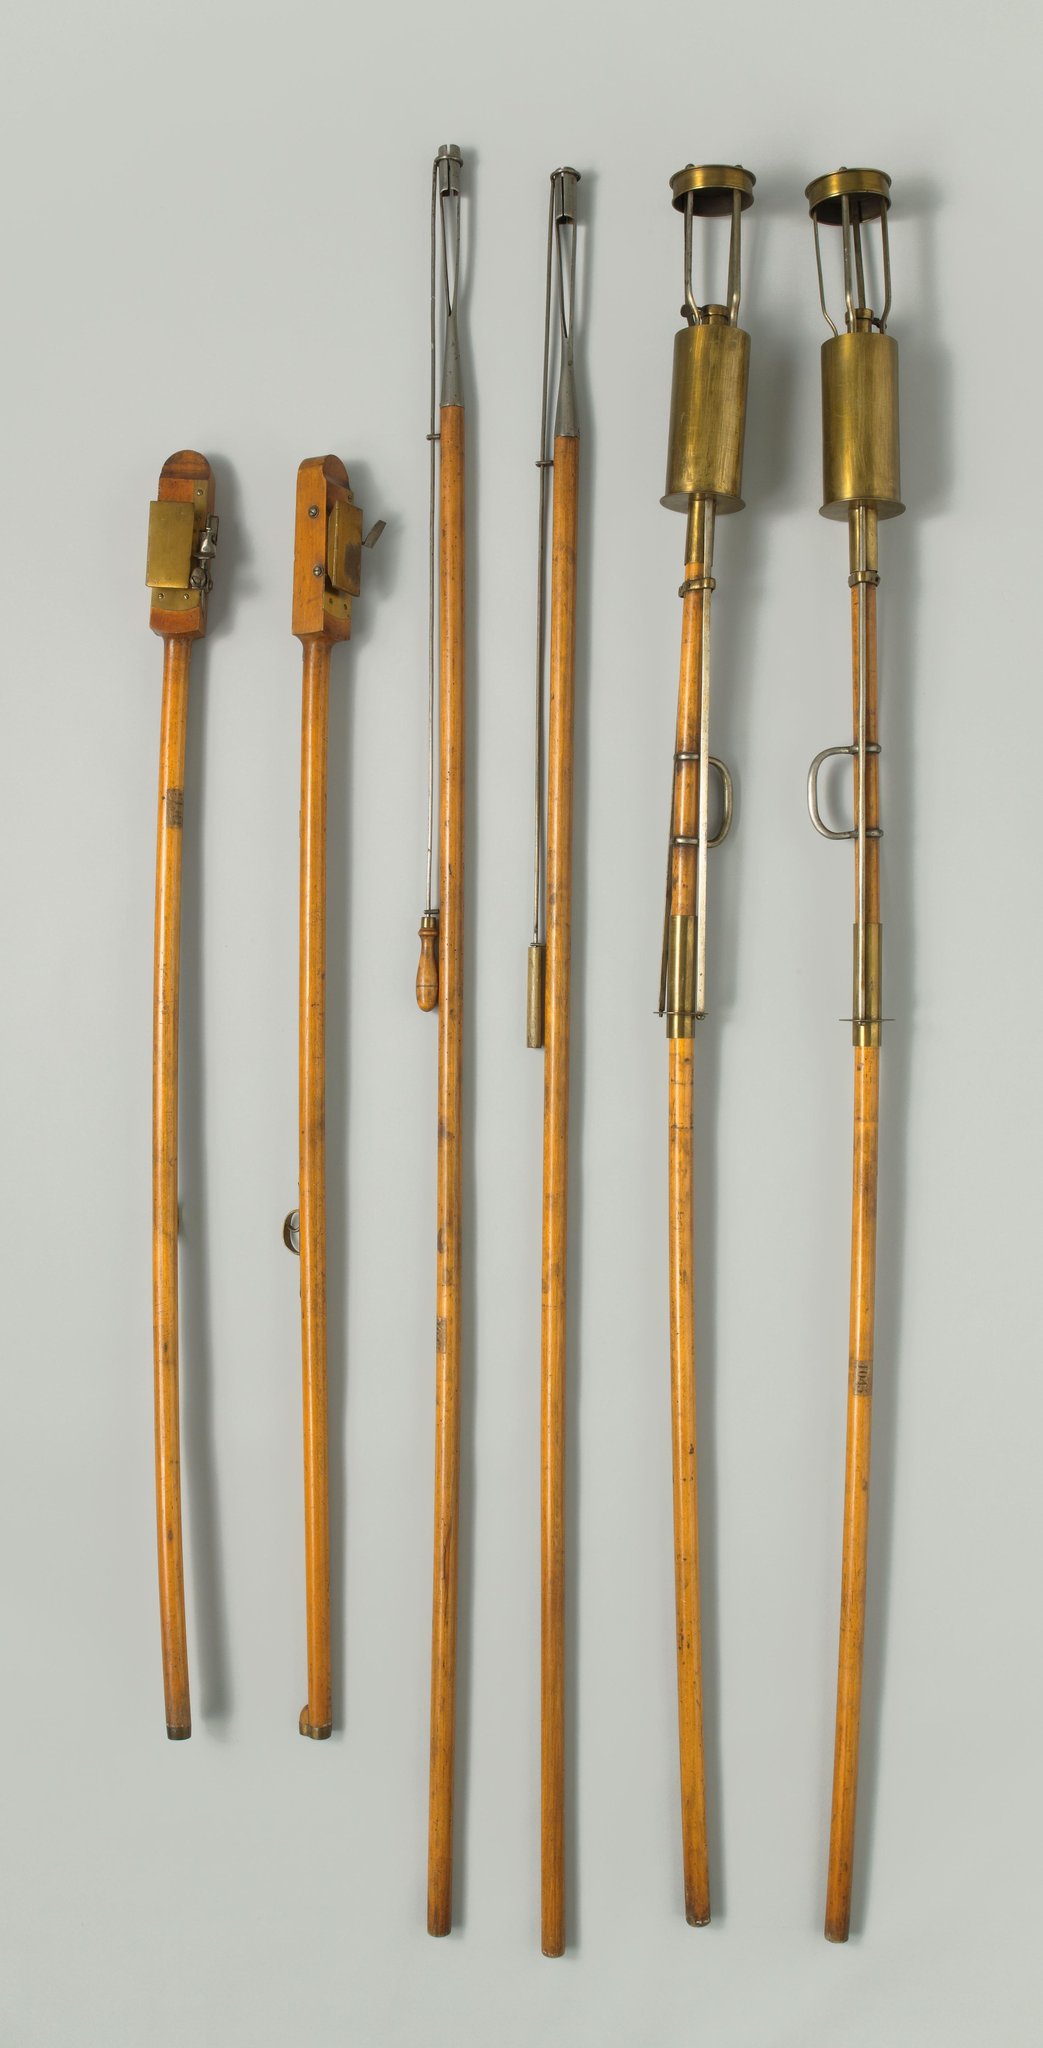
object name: musical instrument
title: Night Signal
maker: Anonymous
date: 1860-1865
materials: brass, iron, wood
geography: russia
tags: siberië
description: Het nachtsignaal bestaat uit een stok met aan het uiteinde een lonthouder, waaroverheen een cylinder geschoven kan worden, die de vlam aan het oog onttrekt.